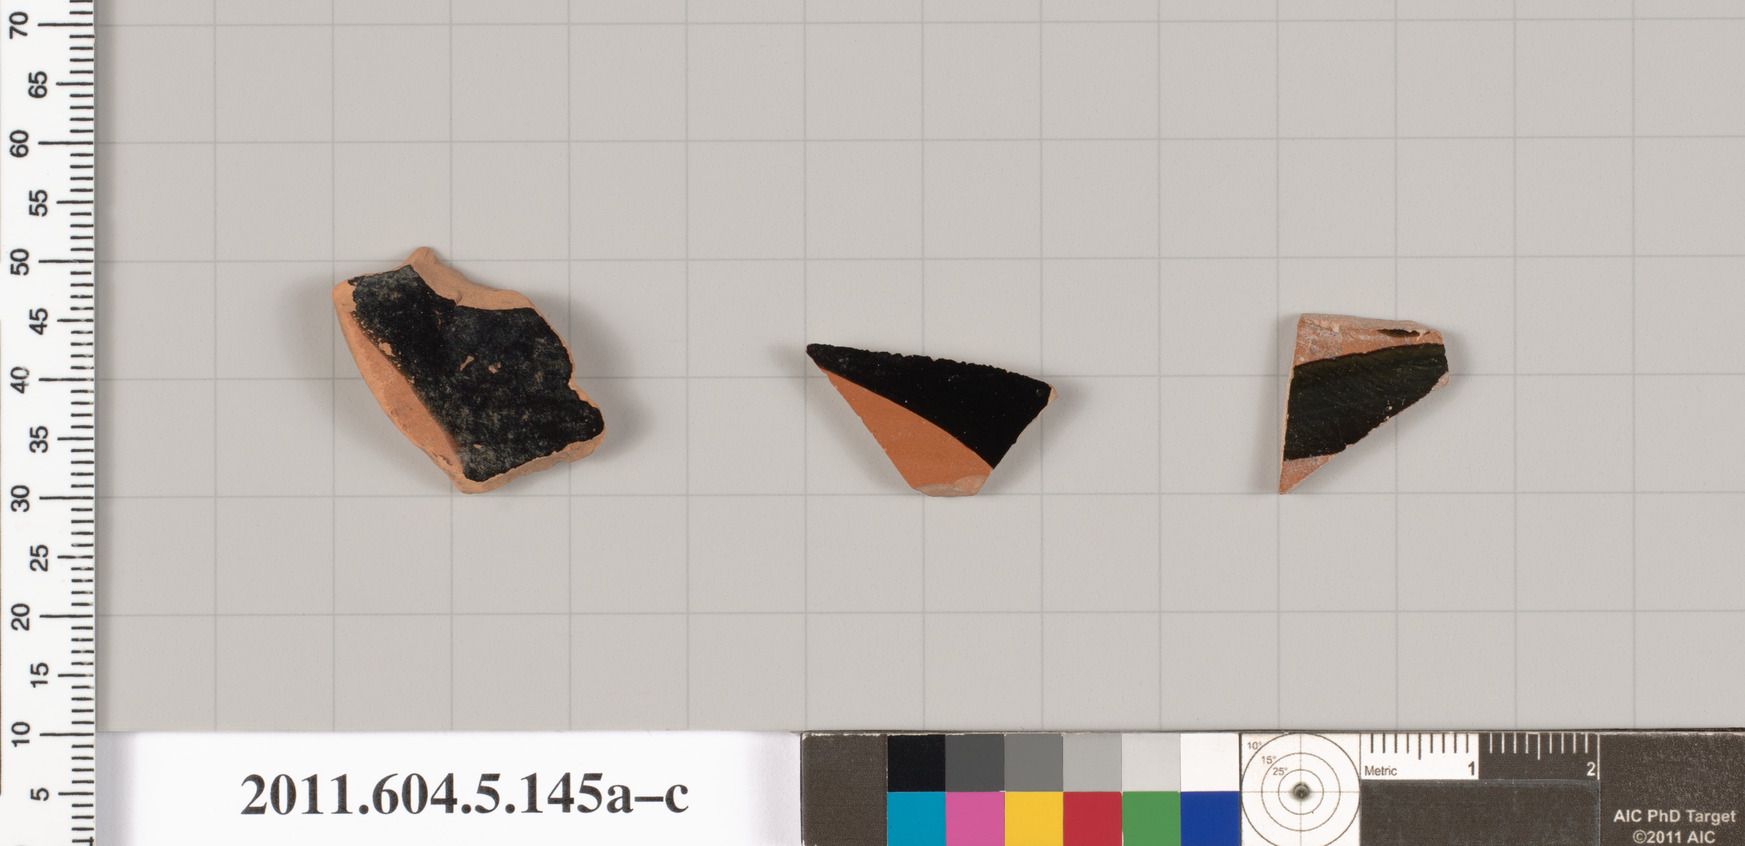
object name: kylix fragment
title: Terracotta fragments of kylikes (drinking cups)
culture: greek, attic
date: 600-401 BCE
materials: terracotta